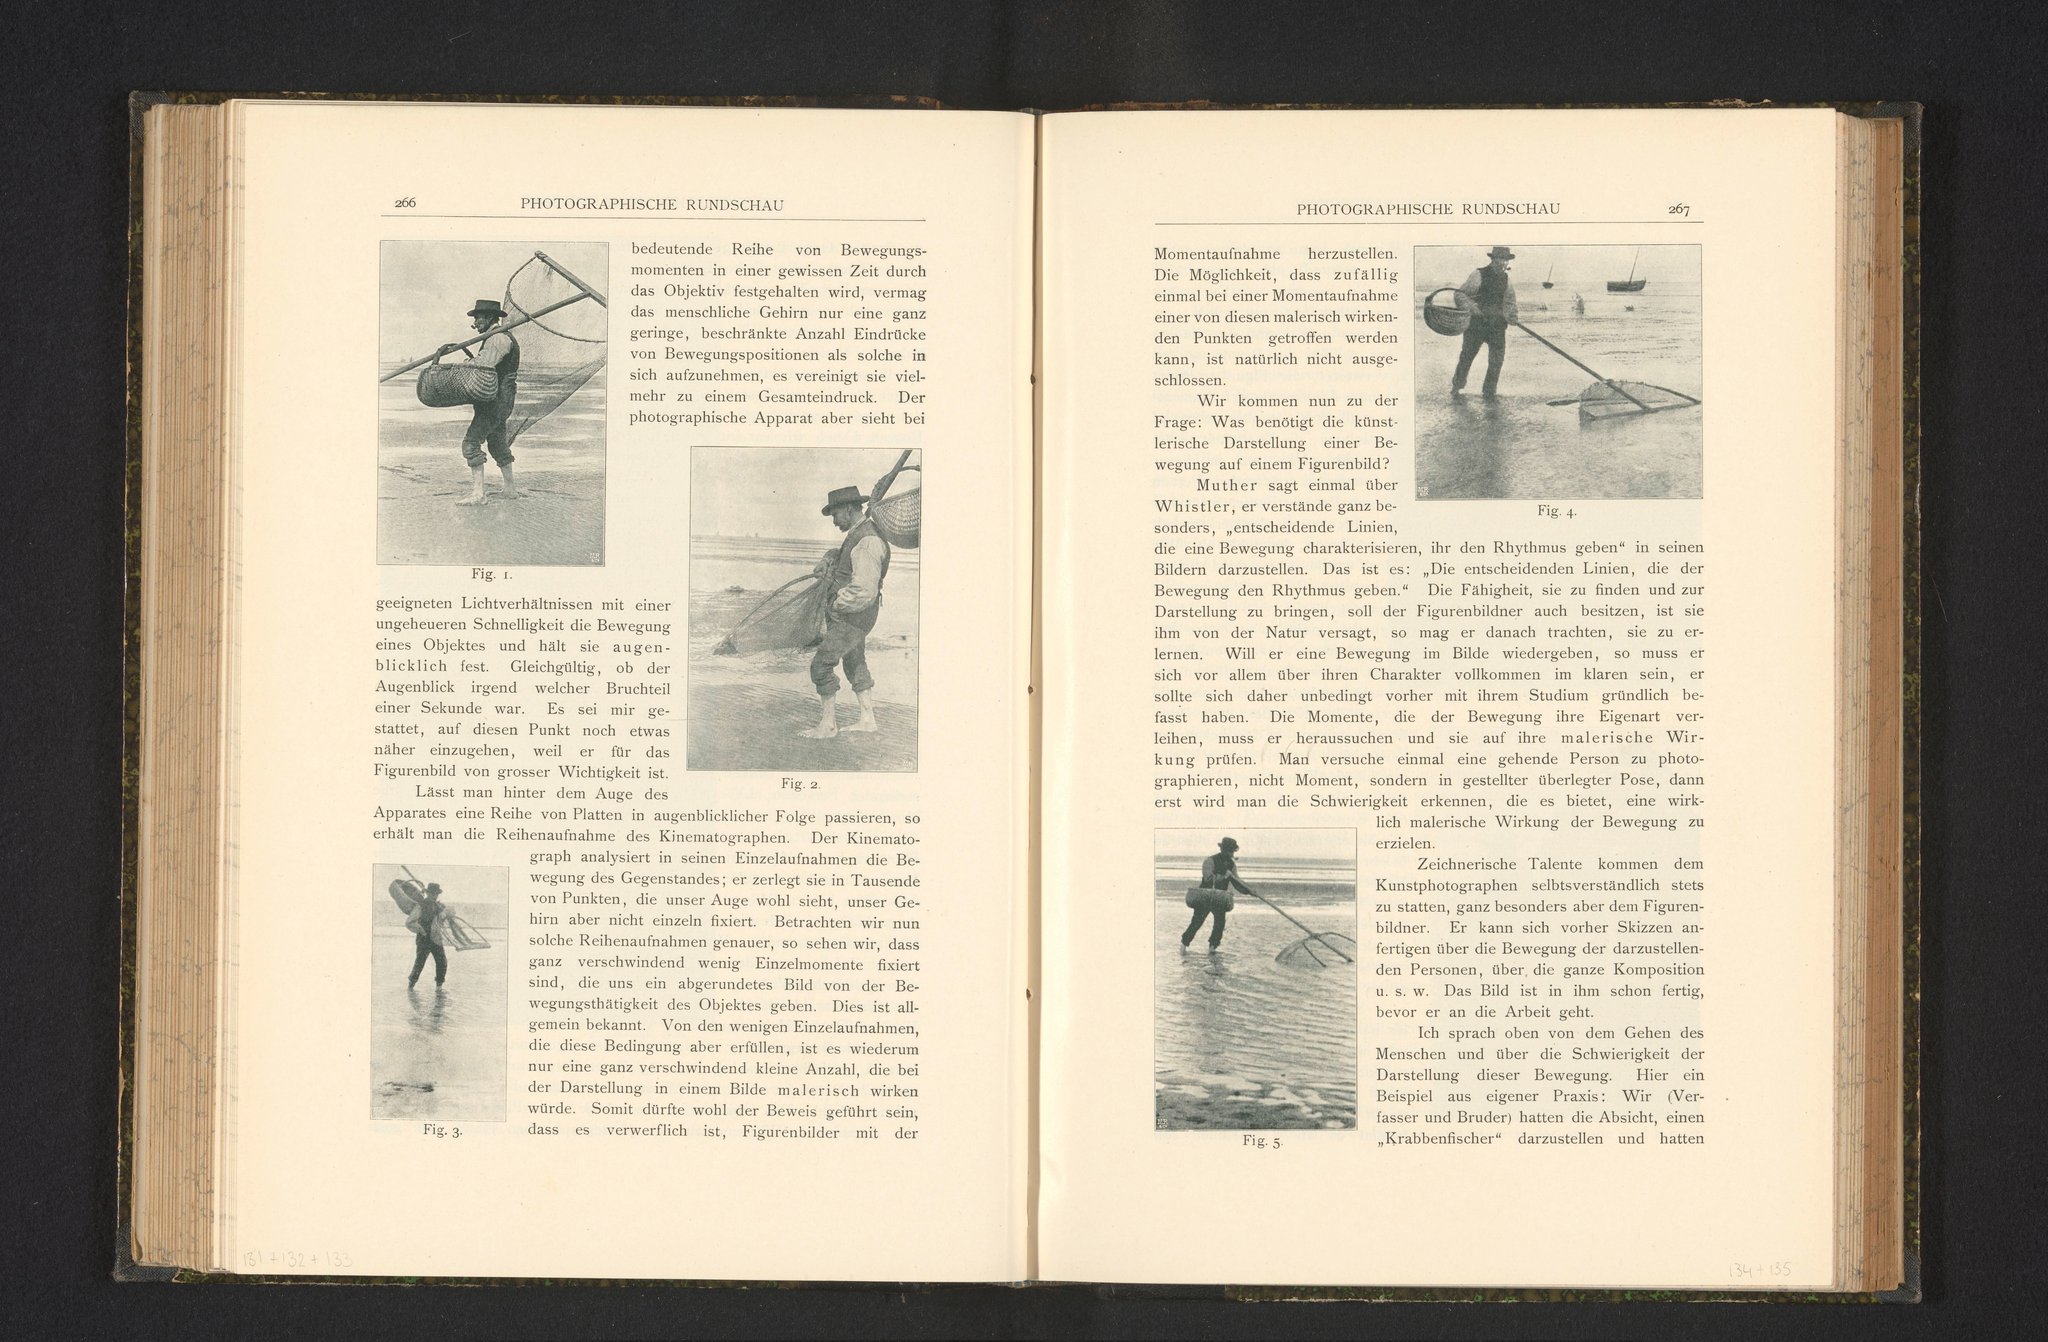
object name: page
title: Gezicht op een visser aan de kust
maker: Anonymous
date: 1893-1898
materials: paper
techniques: autotype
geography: berlin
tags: coast, fisherman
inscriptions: monogram: ‘MR/ &Co’